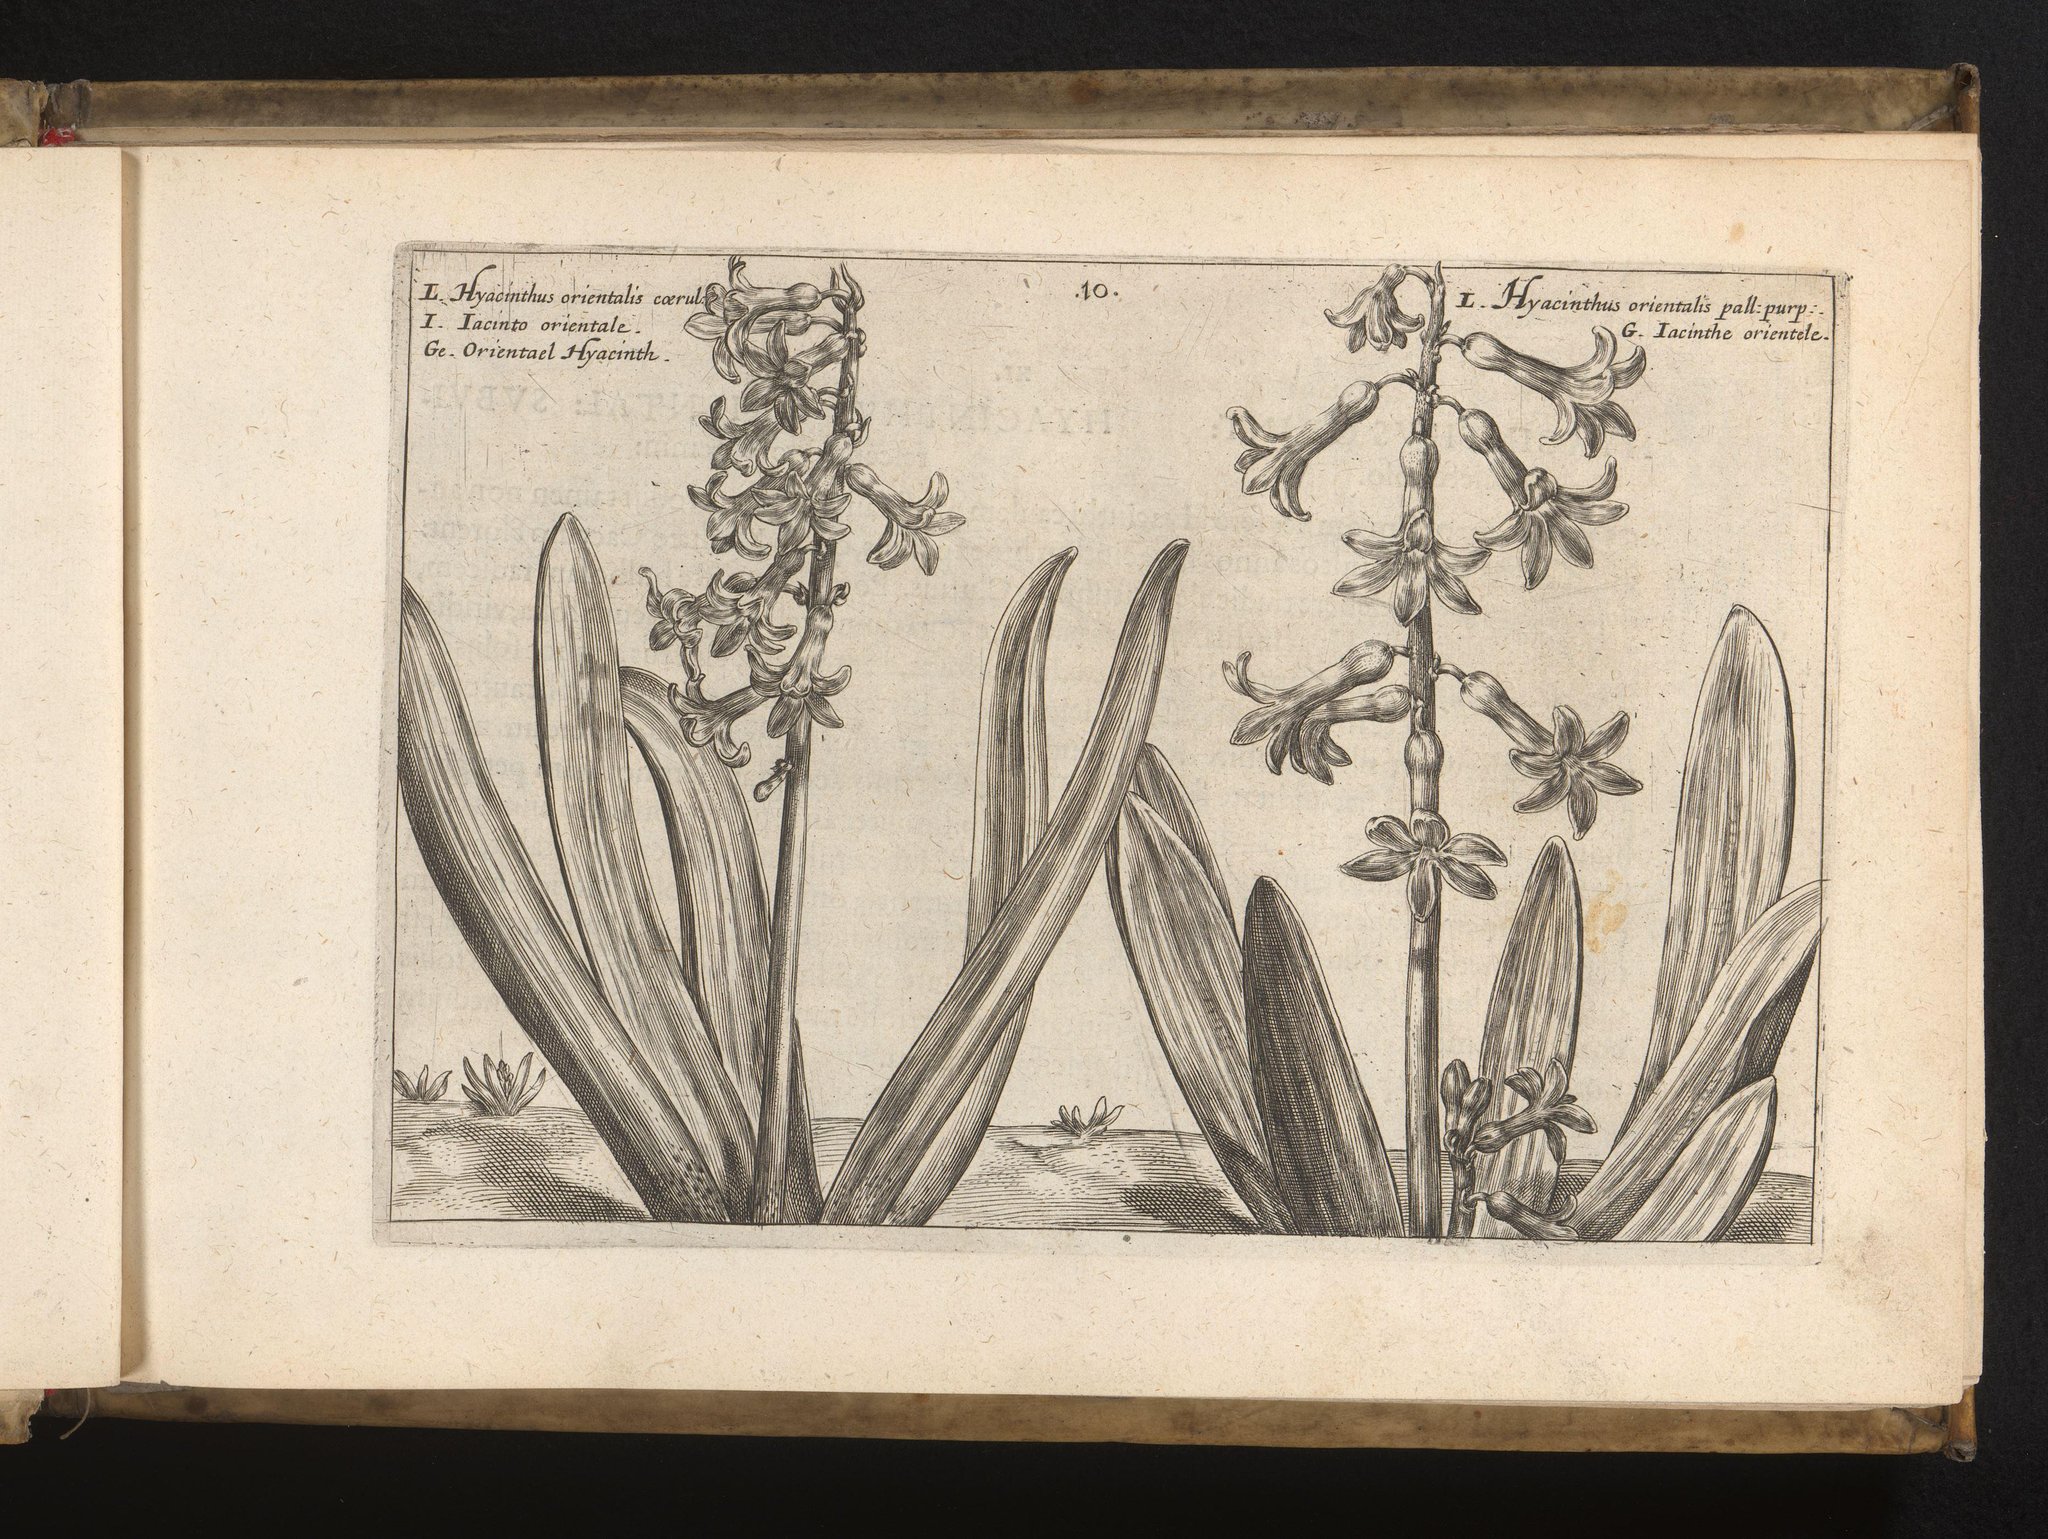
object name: book illustration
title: Bloementuin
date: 1617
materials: paper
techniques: engraving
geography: utrecht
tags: flowers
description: Prent uit: Passe, Crispijn van de (II). Hortus floridus in quo rariorum & minus vulgarium florum icones ad vivam veramque formam. Arnhem: Johannes Janssonius, 1617.